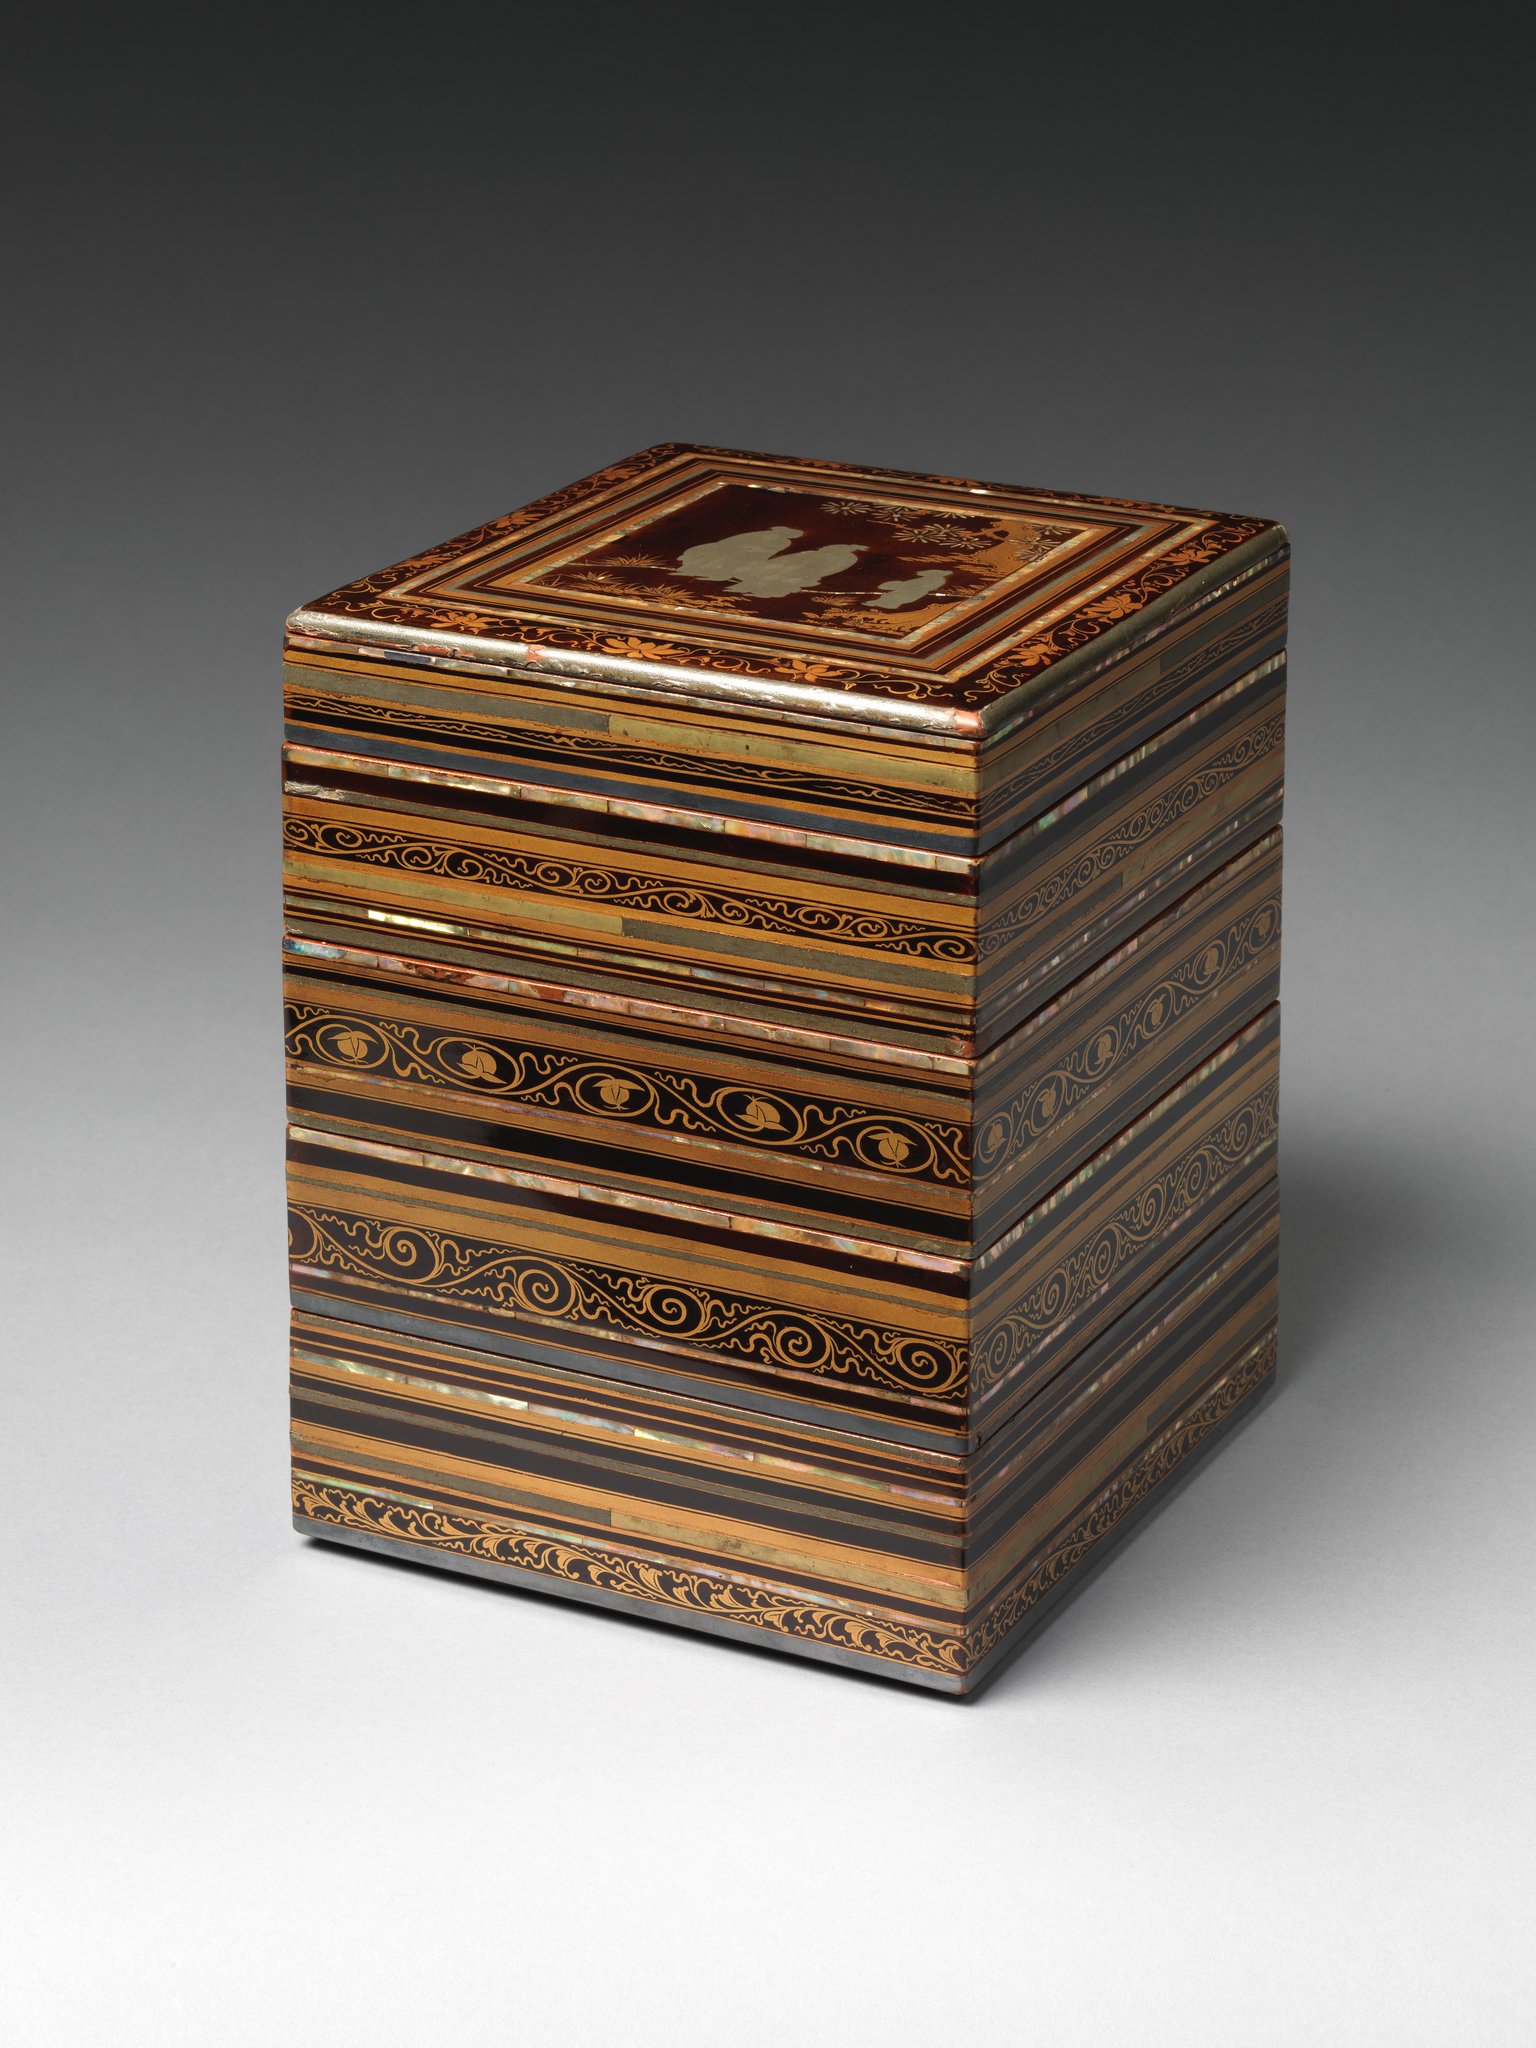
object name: food box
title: Food Box with Striped Decoration and Chinese Figures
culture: japanese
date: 1601-1700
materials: gold, lead, pearl, silver, wood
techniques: hiramakie, inlay, lacquer